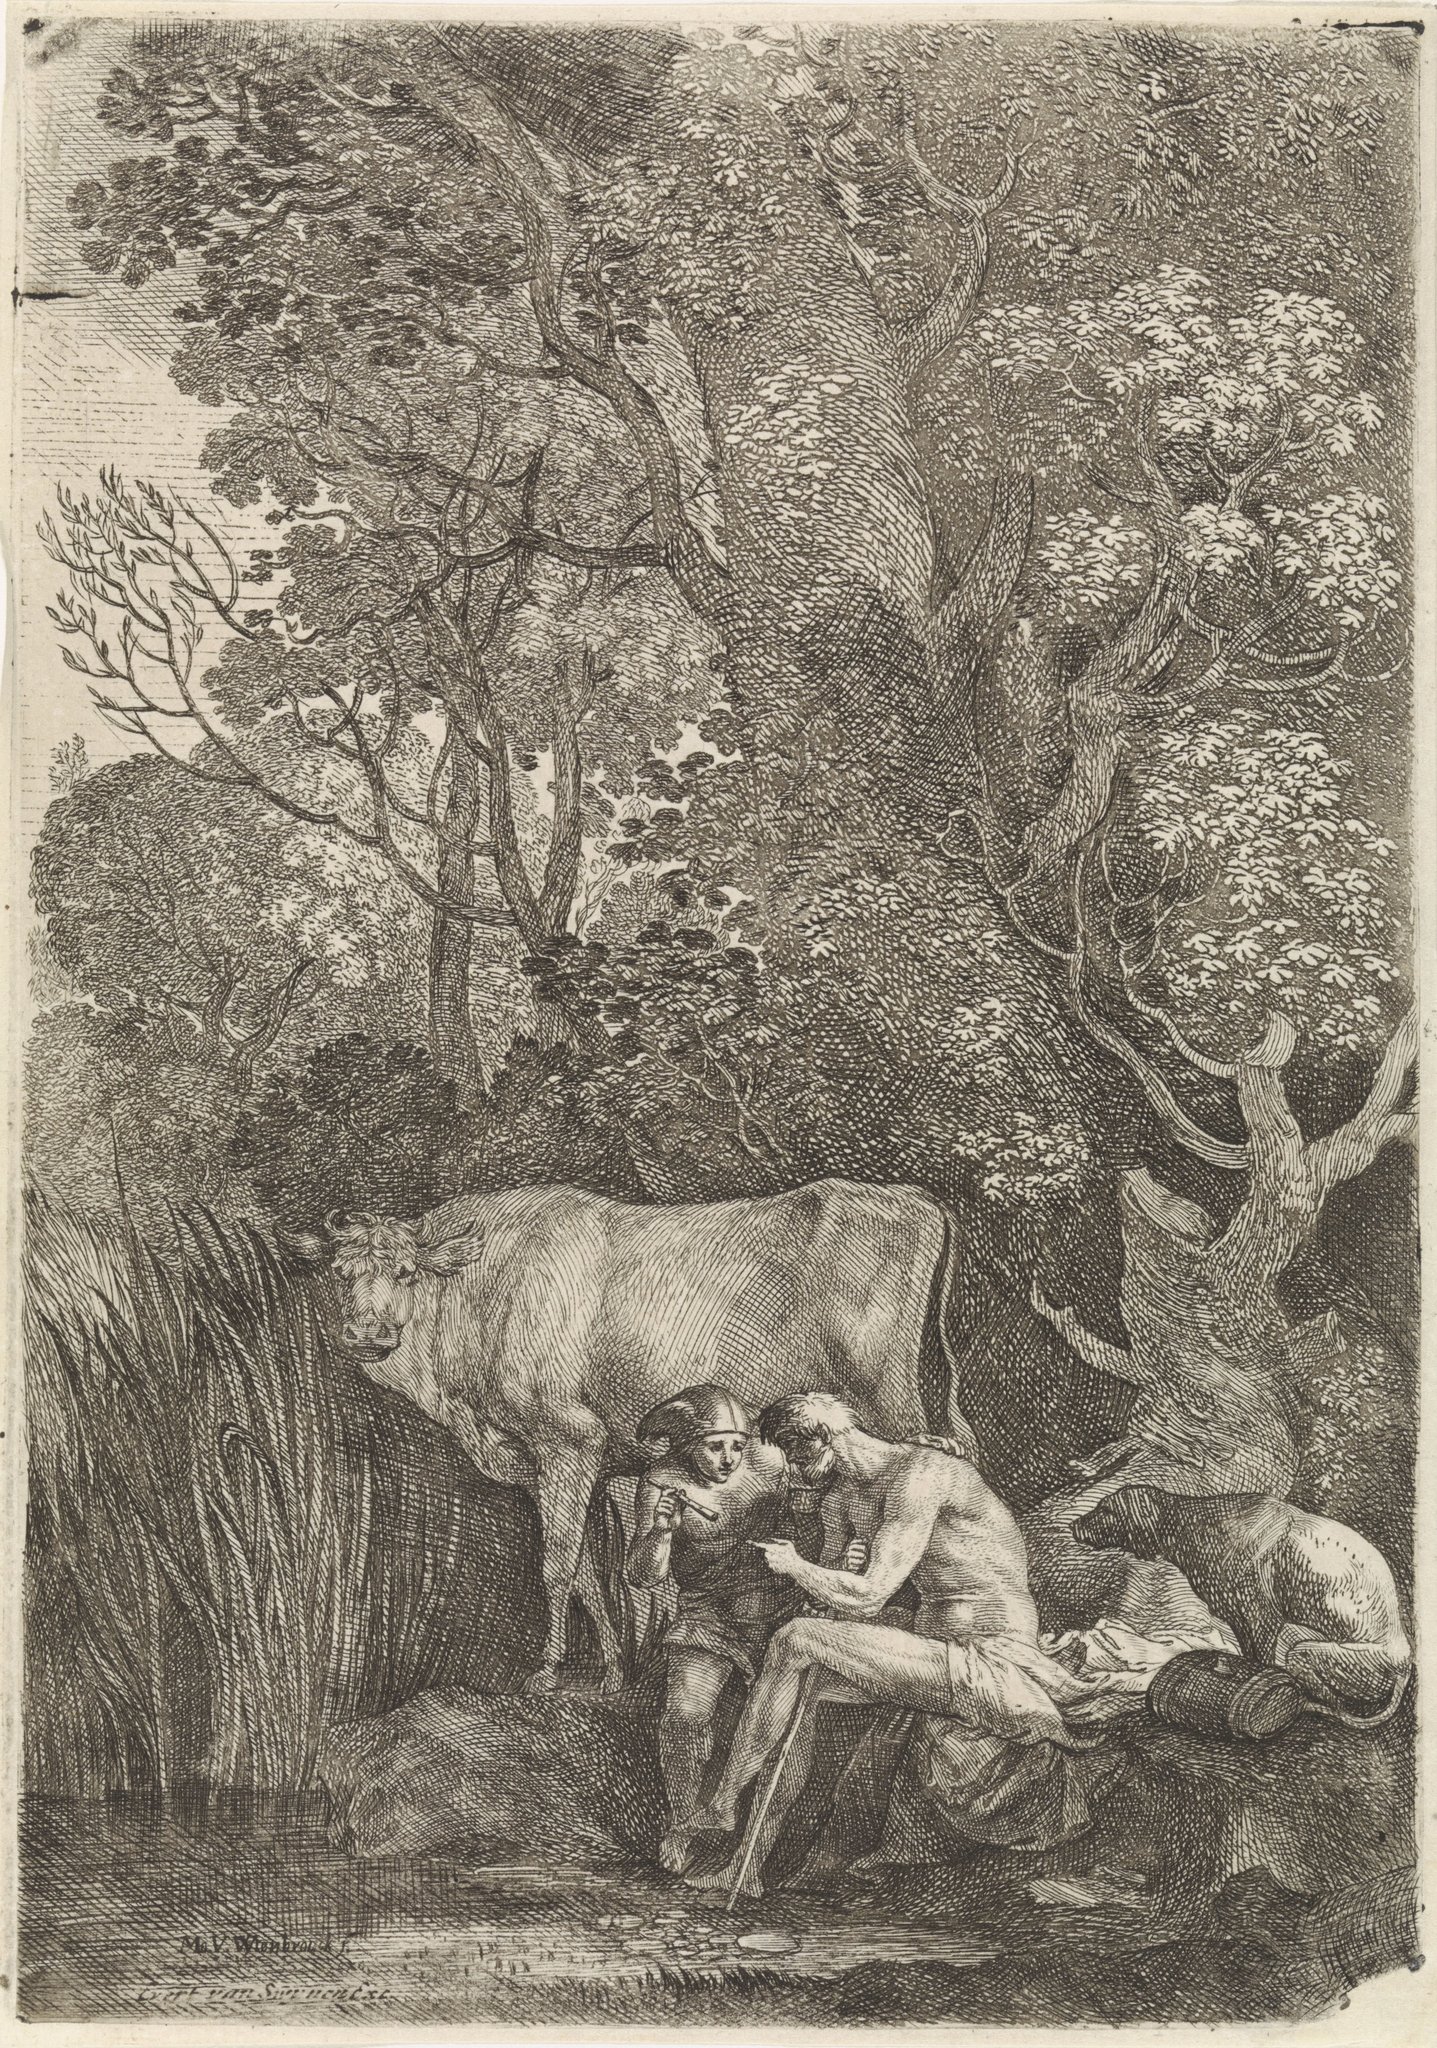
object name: print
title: Mercurius sust Argus in slaap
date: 1600-1647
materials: paper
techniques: engraving, etching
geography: the hague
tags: mercury lulls argus into sleep by making music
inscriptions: collector's mark: Lugt 2228, collector's mark: Lugt 2610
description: Mercurius is in gesprek met de reus Argus. Hij houdt zijn fluit in de hand. Achter Mercurius en Argus staat de koe Io. Scène uit Ovidius’ Metamorfosen (Met. I, 682-687).